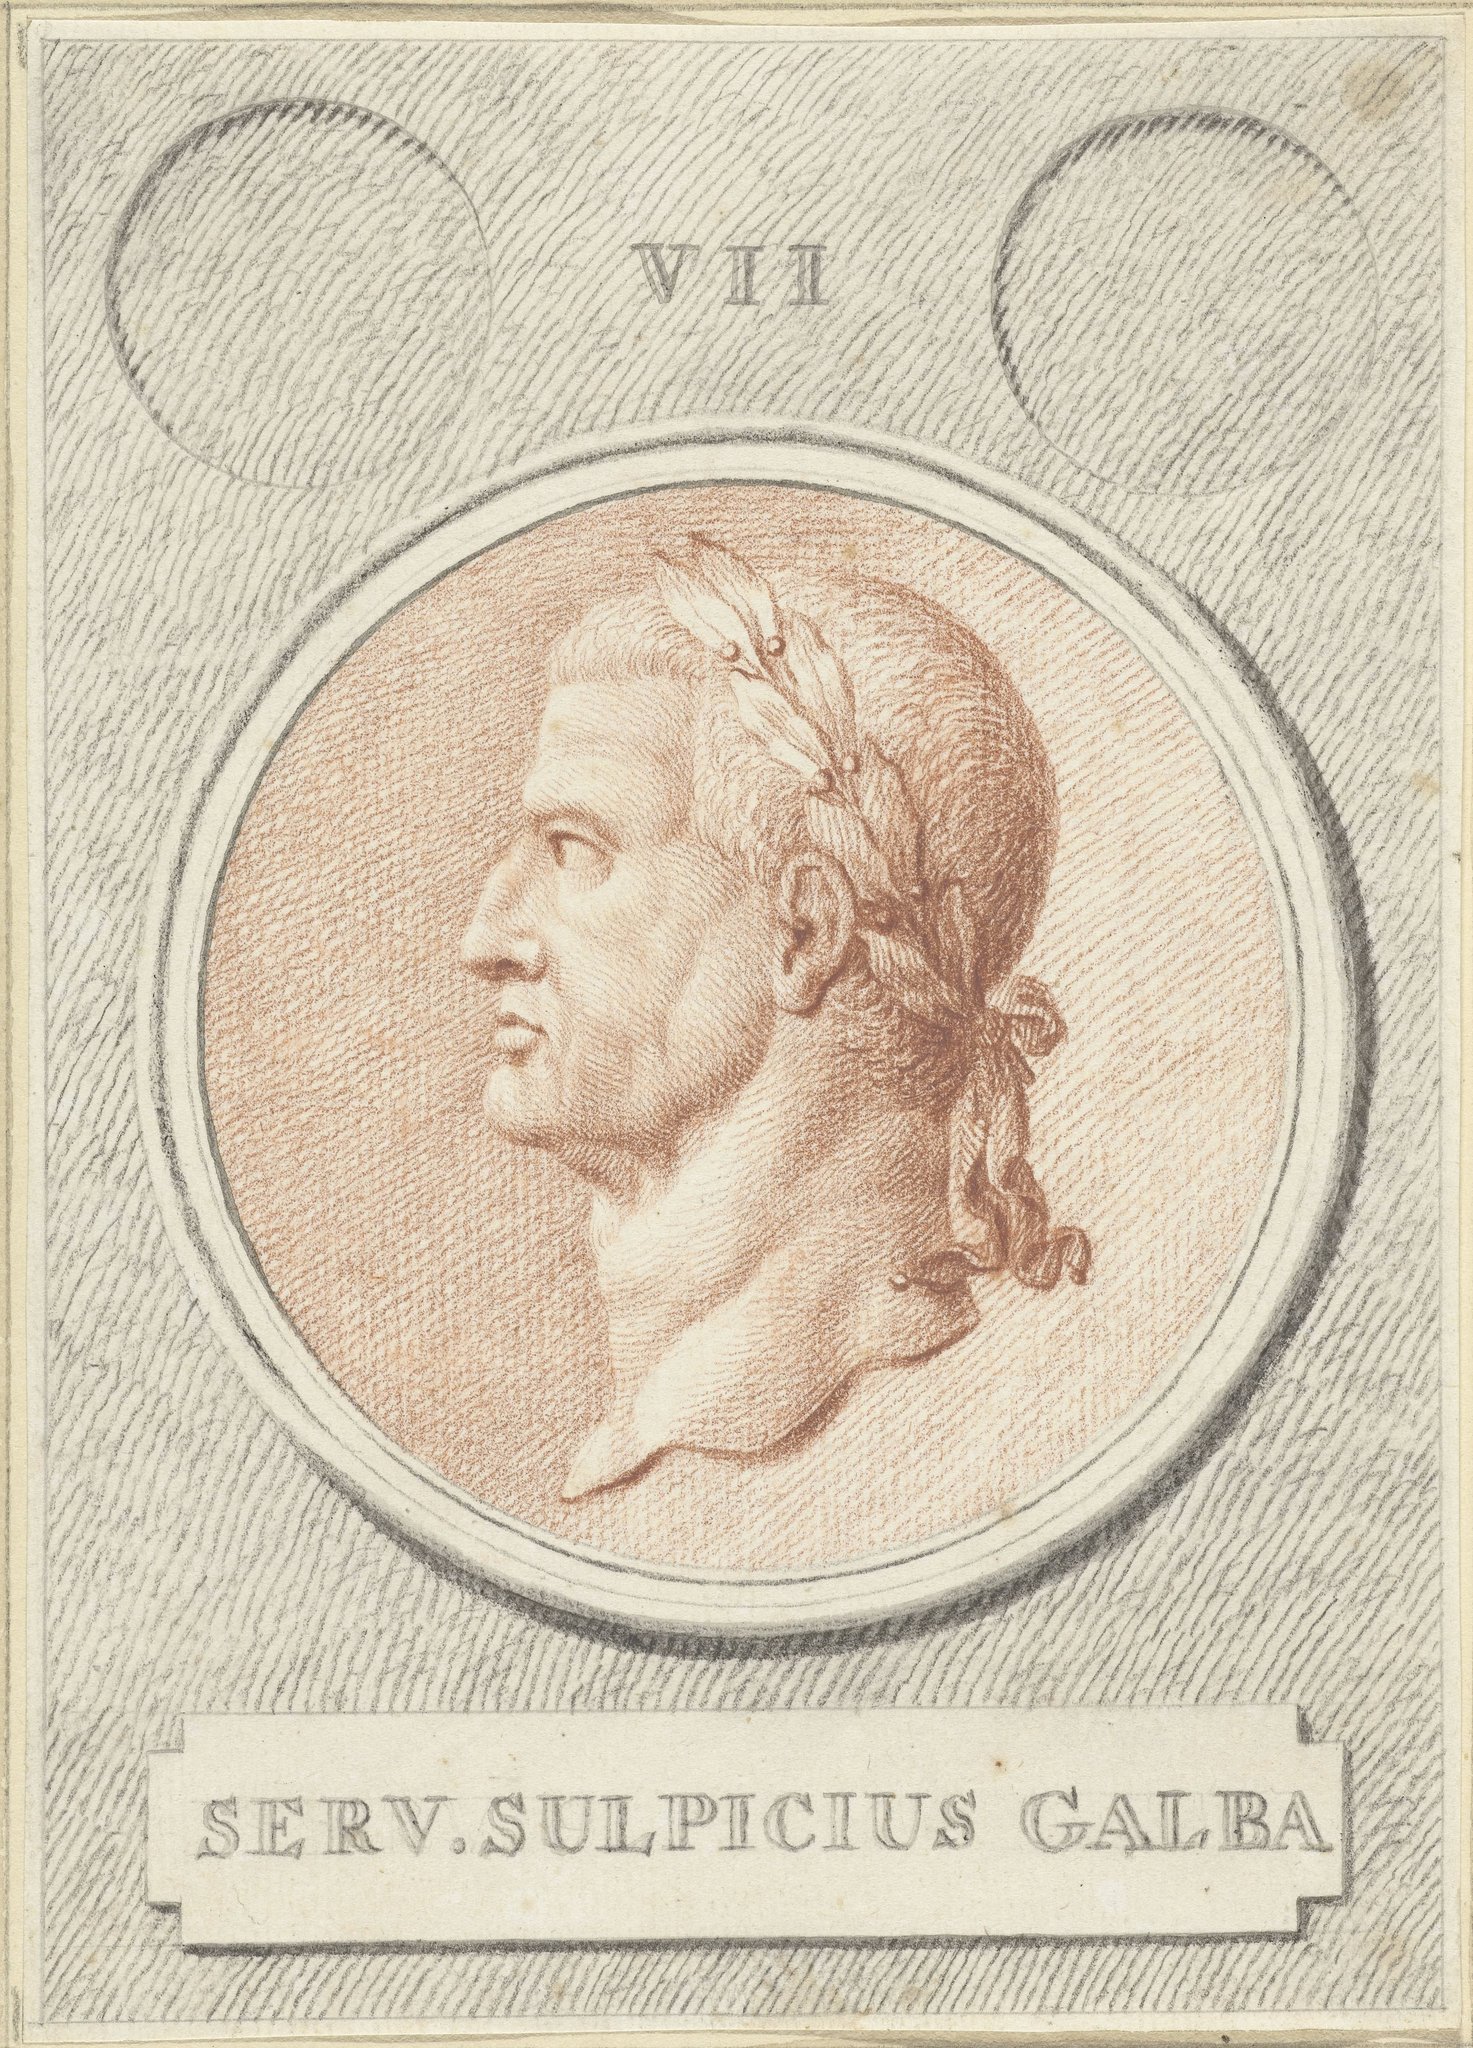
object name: drawing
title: Portretmedaillon van Galba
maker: jan caspar philips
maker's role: draughtsman, print maker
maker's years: 1700-1775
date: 1736-1775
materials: chalk, ink, paper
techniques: brush, pen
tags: male persons from classical history (galba) - non-aggressive activities of person from classical history, historical persons